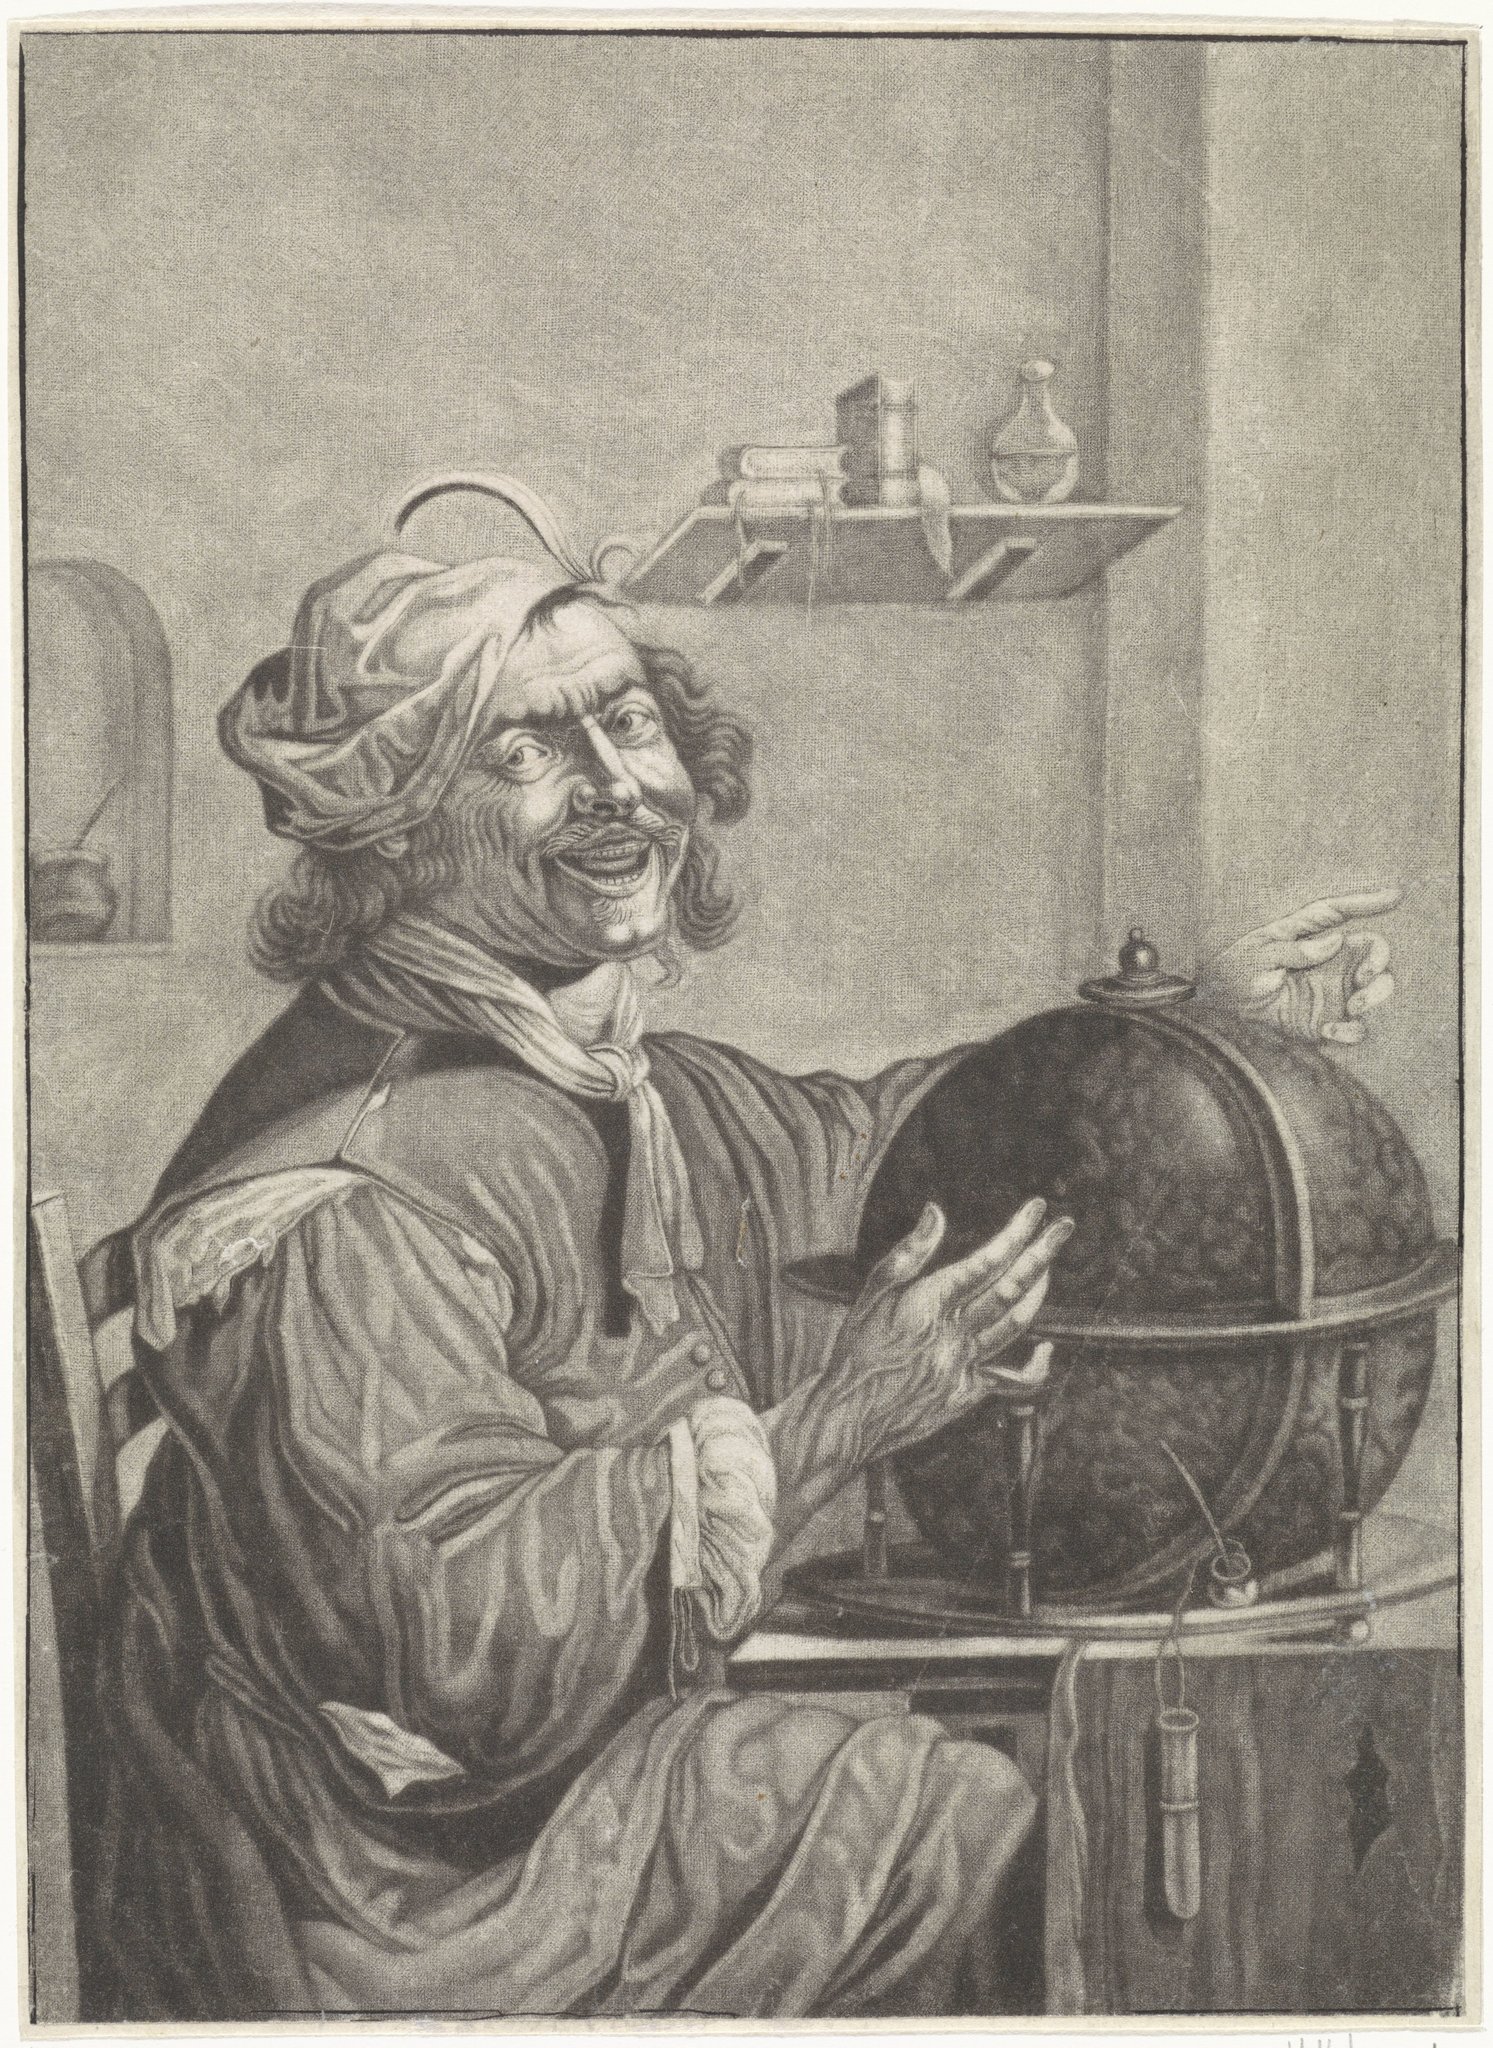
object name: print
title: Democritus lacht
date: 1661-1726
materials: paper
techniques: mezzotint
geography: amsterdam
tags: laughing, globe, (story of) democritus, the philosopher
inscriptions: collector's mark: Lugt 2228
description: De Griekse filosoof Democritus zit in zijn werkkamer bij een aardbol en lacht.